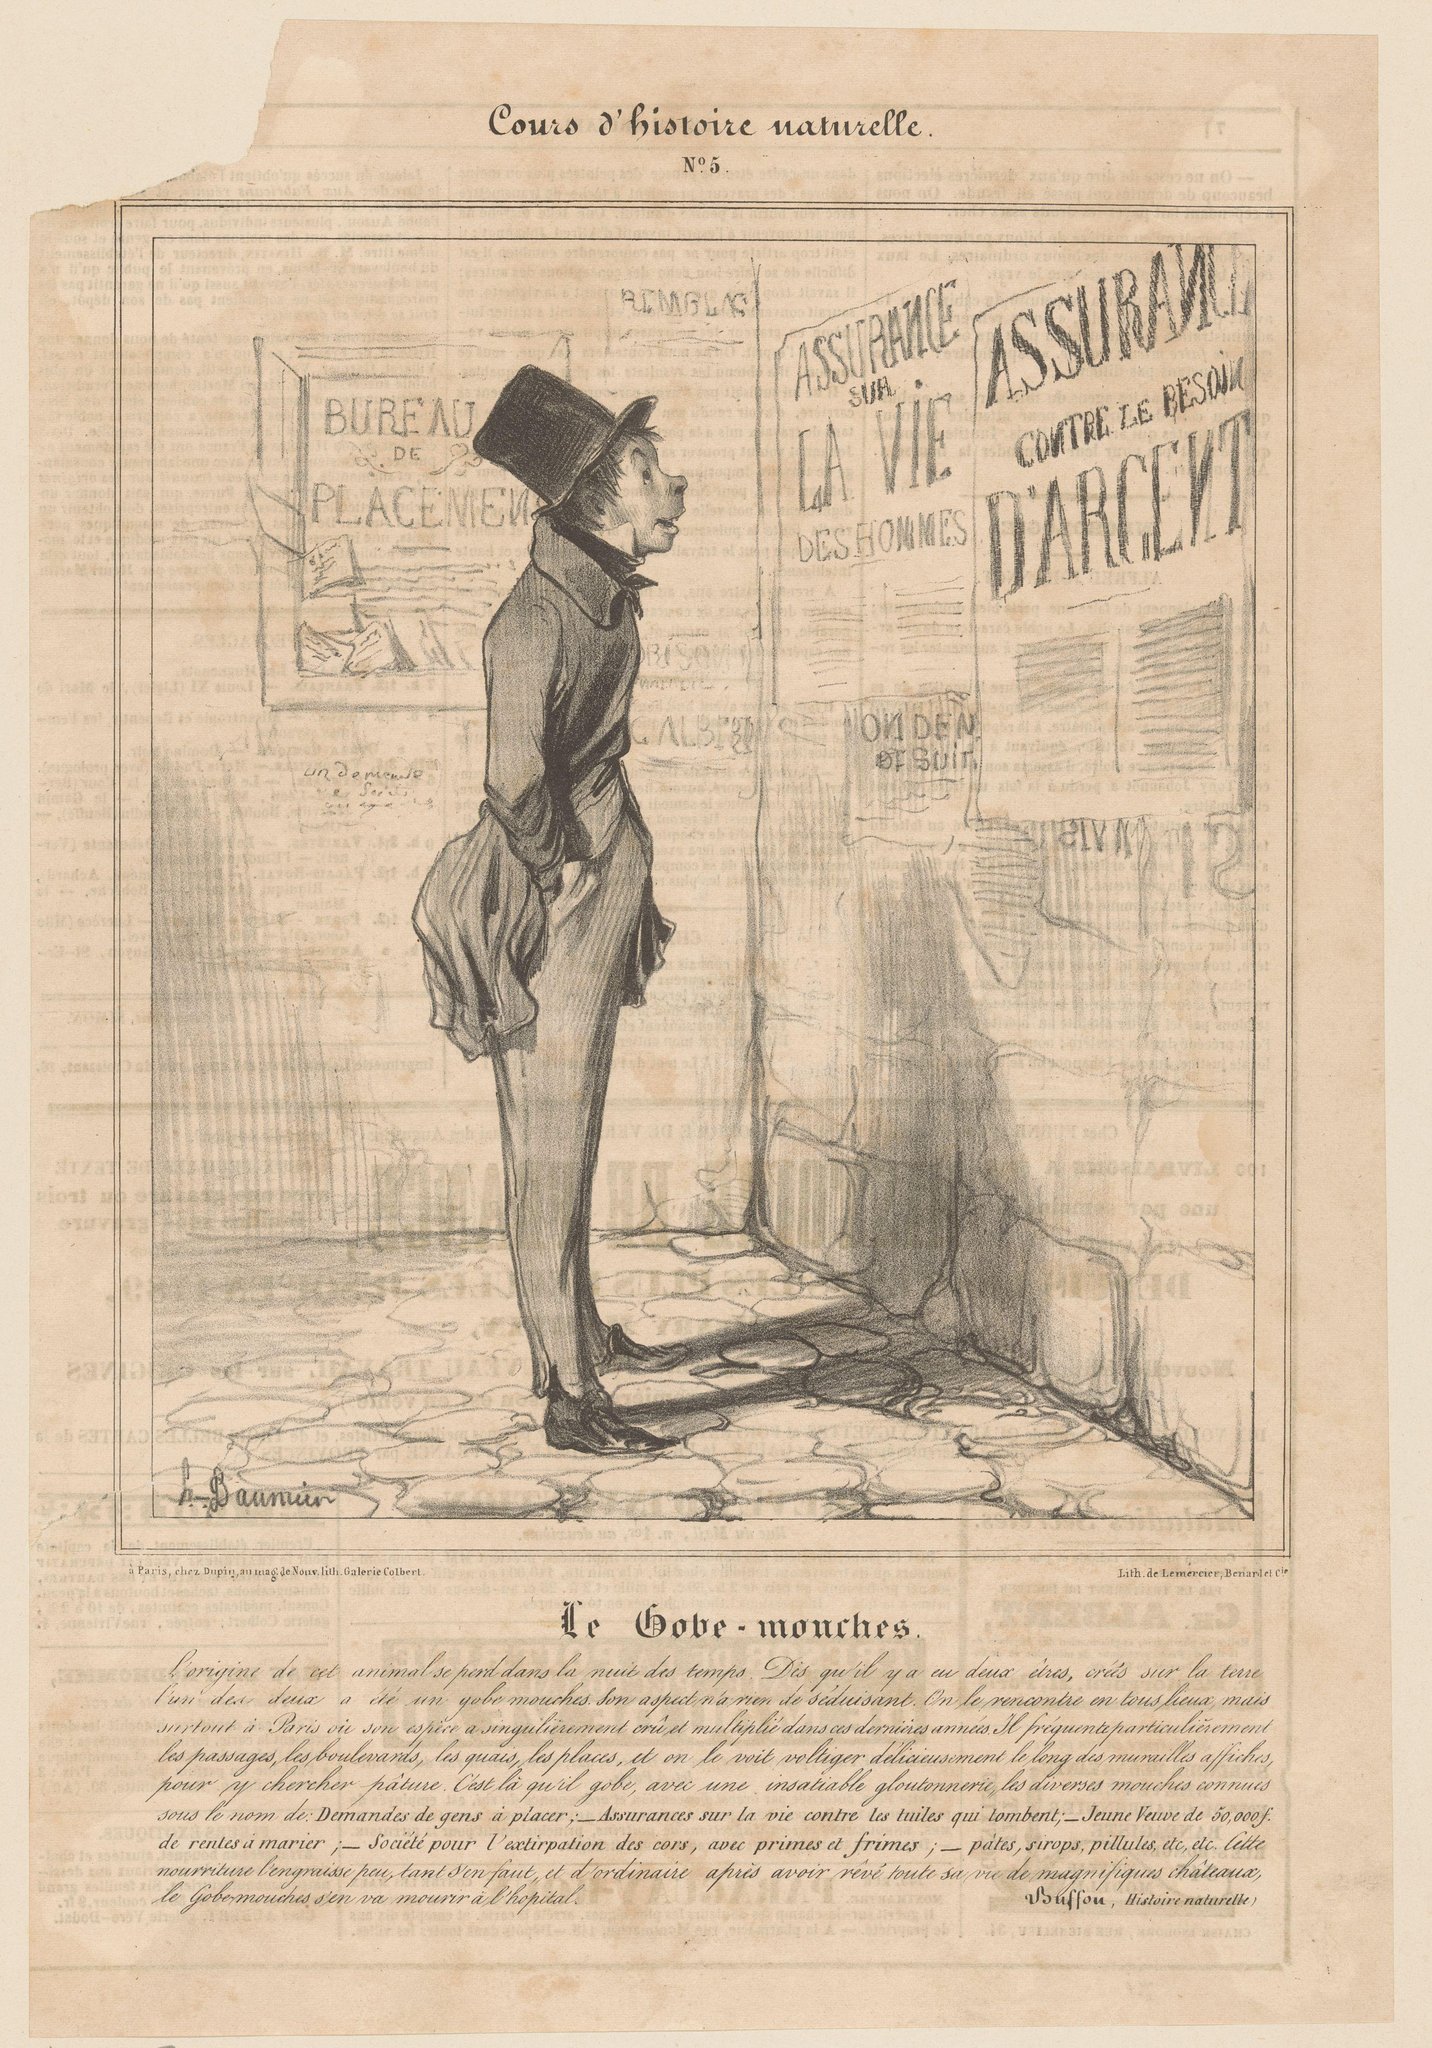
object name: cartoon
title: Cours d'histoire naturelle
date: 1837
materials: paper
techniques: letterpress printing, lithograph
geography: paris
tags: insurance, caricatures (human types), poster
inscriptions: collector's mark: Lugt 2228a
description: De verzekeraars worden vergeleken met vliegenvangers.